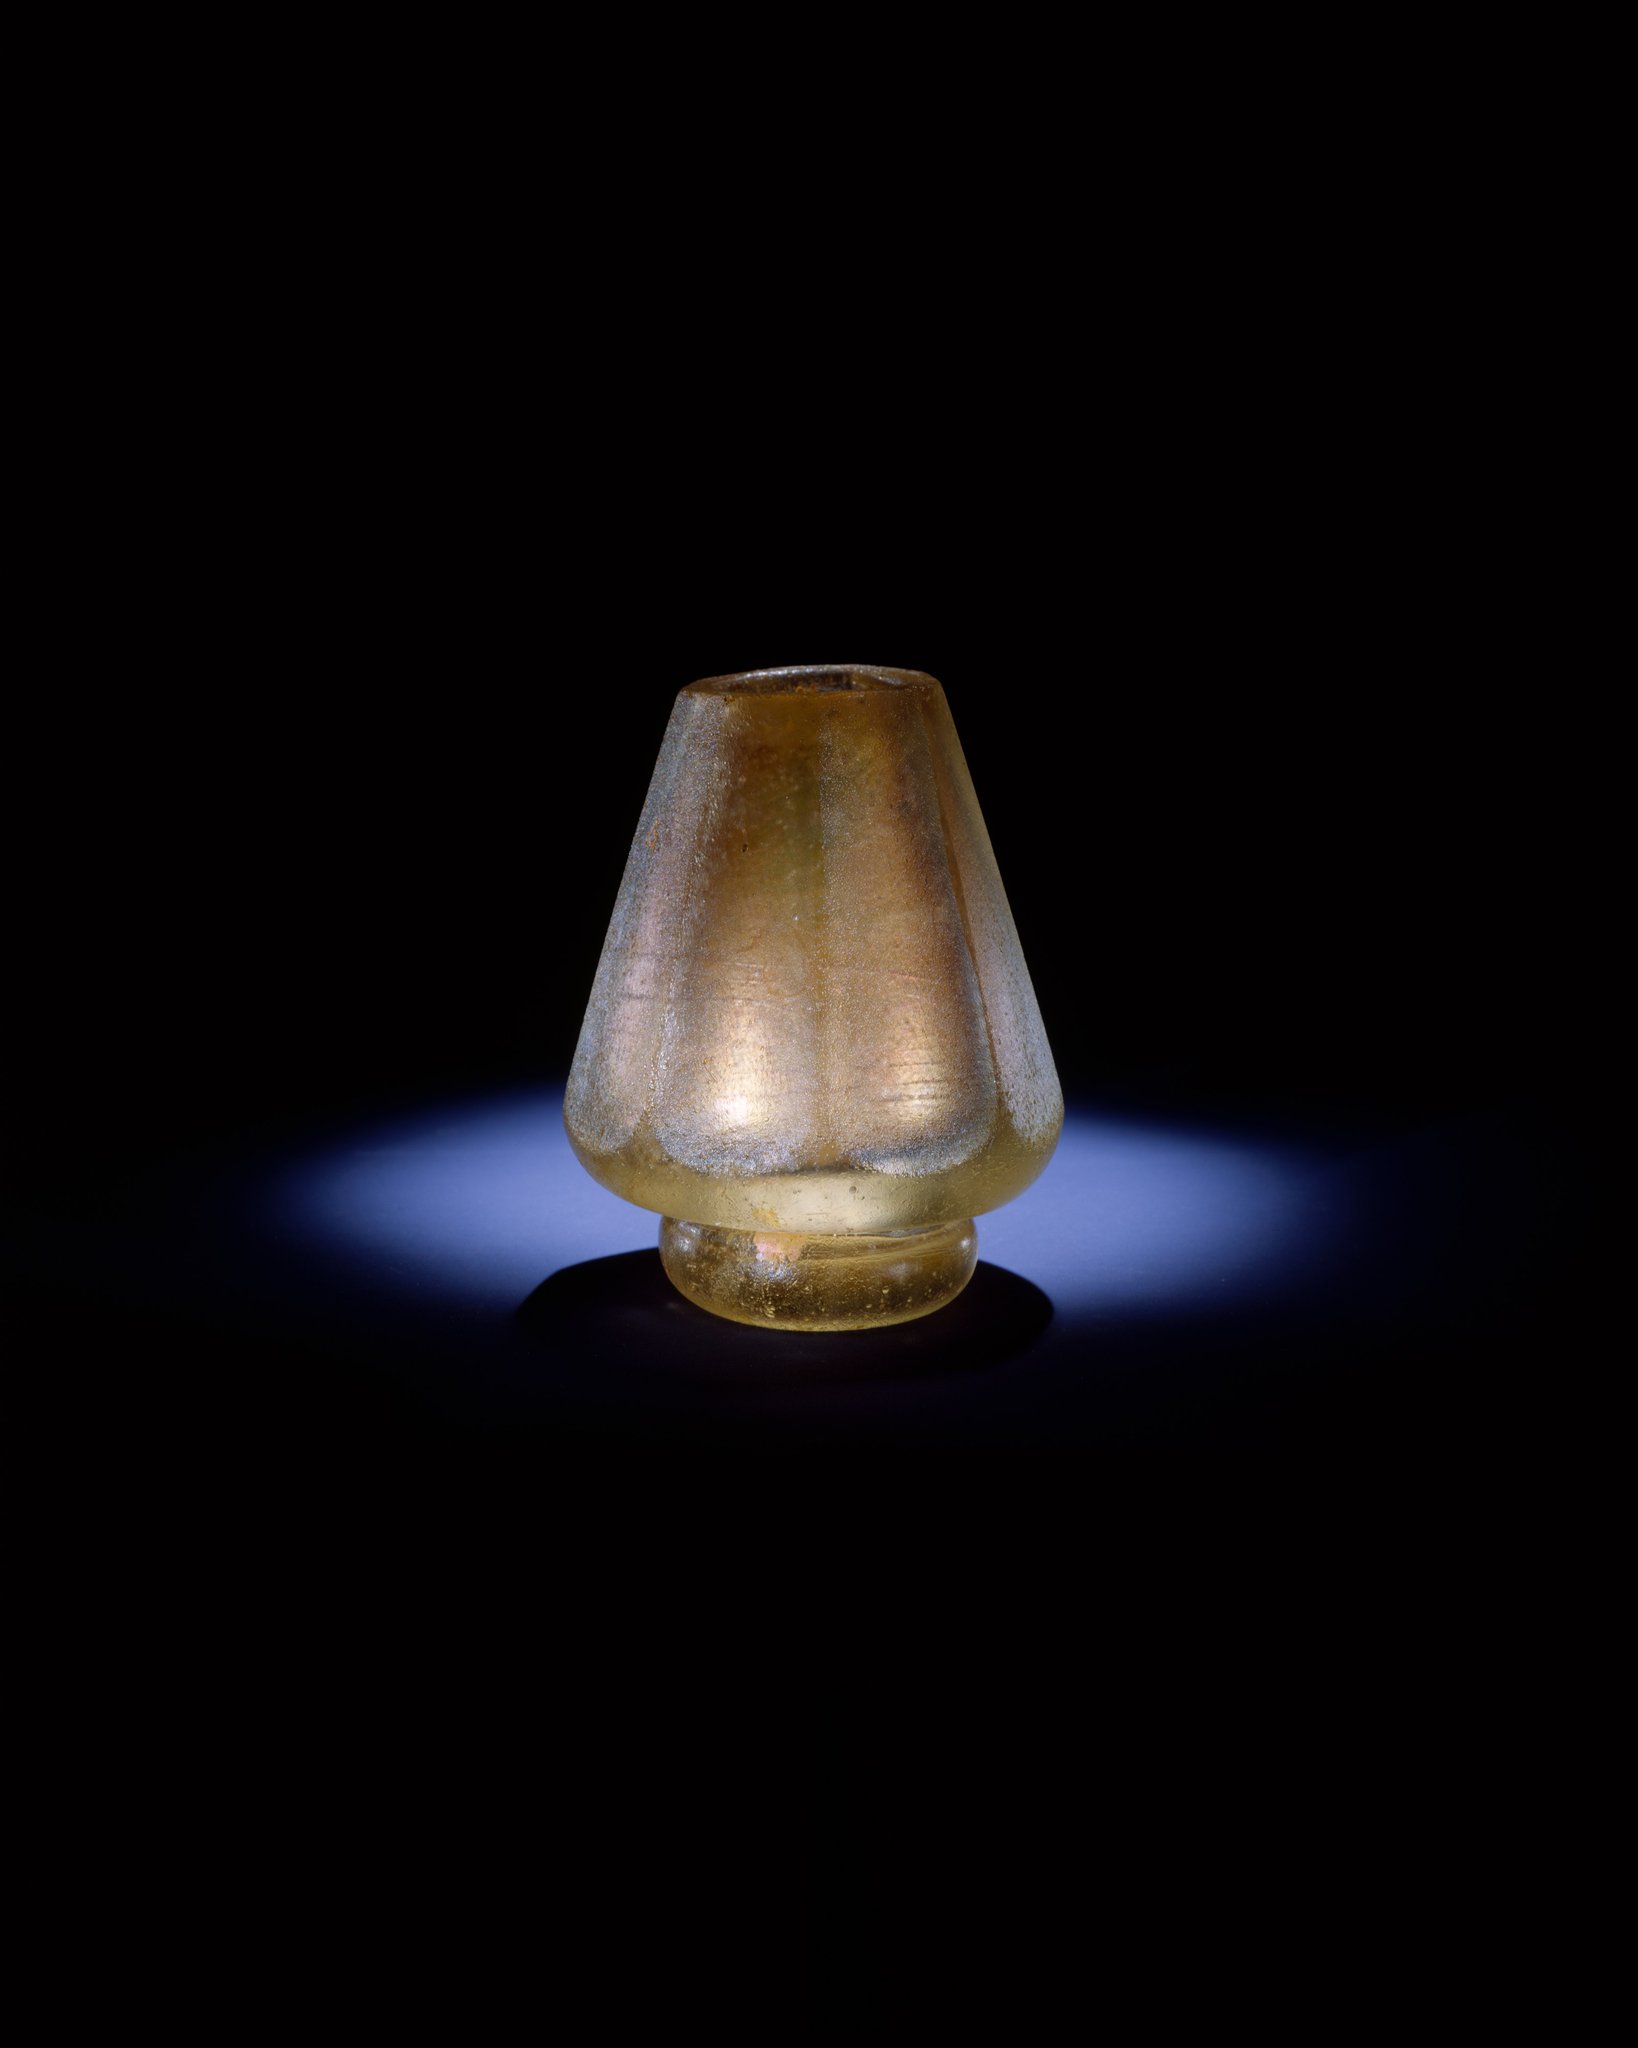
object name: bottle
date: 801-1000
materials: glass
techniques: glassblowing, cutting, tooling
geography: iran